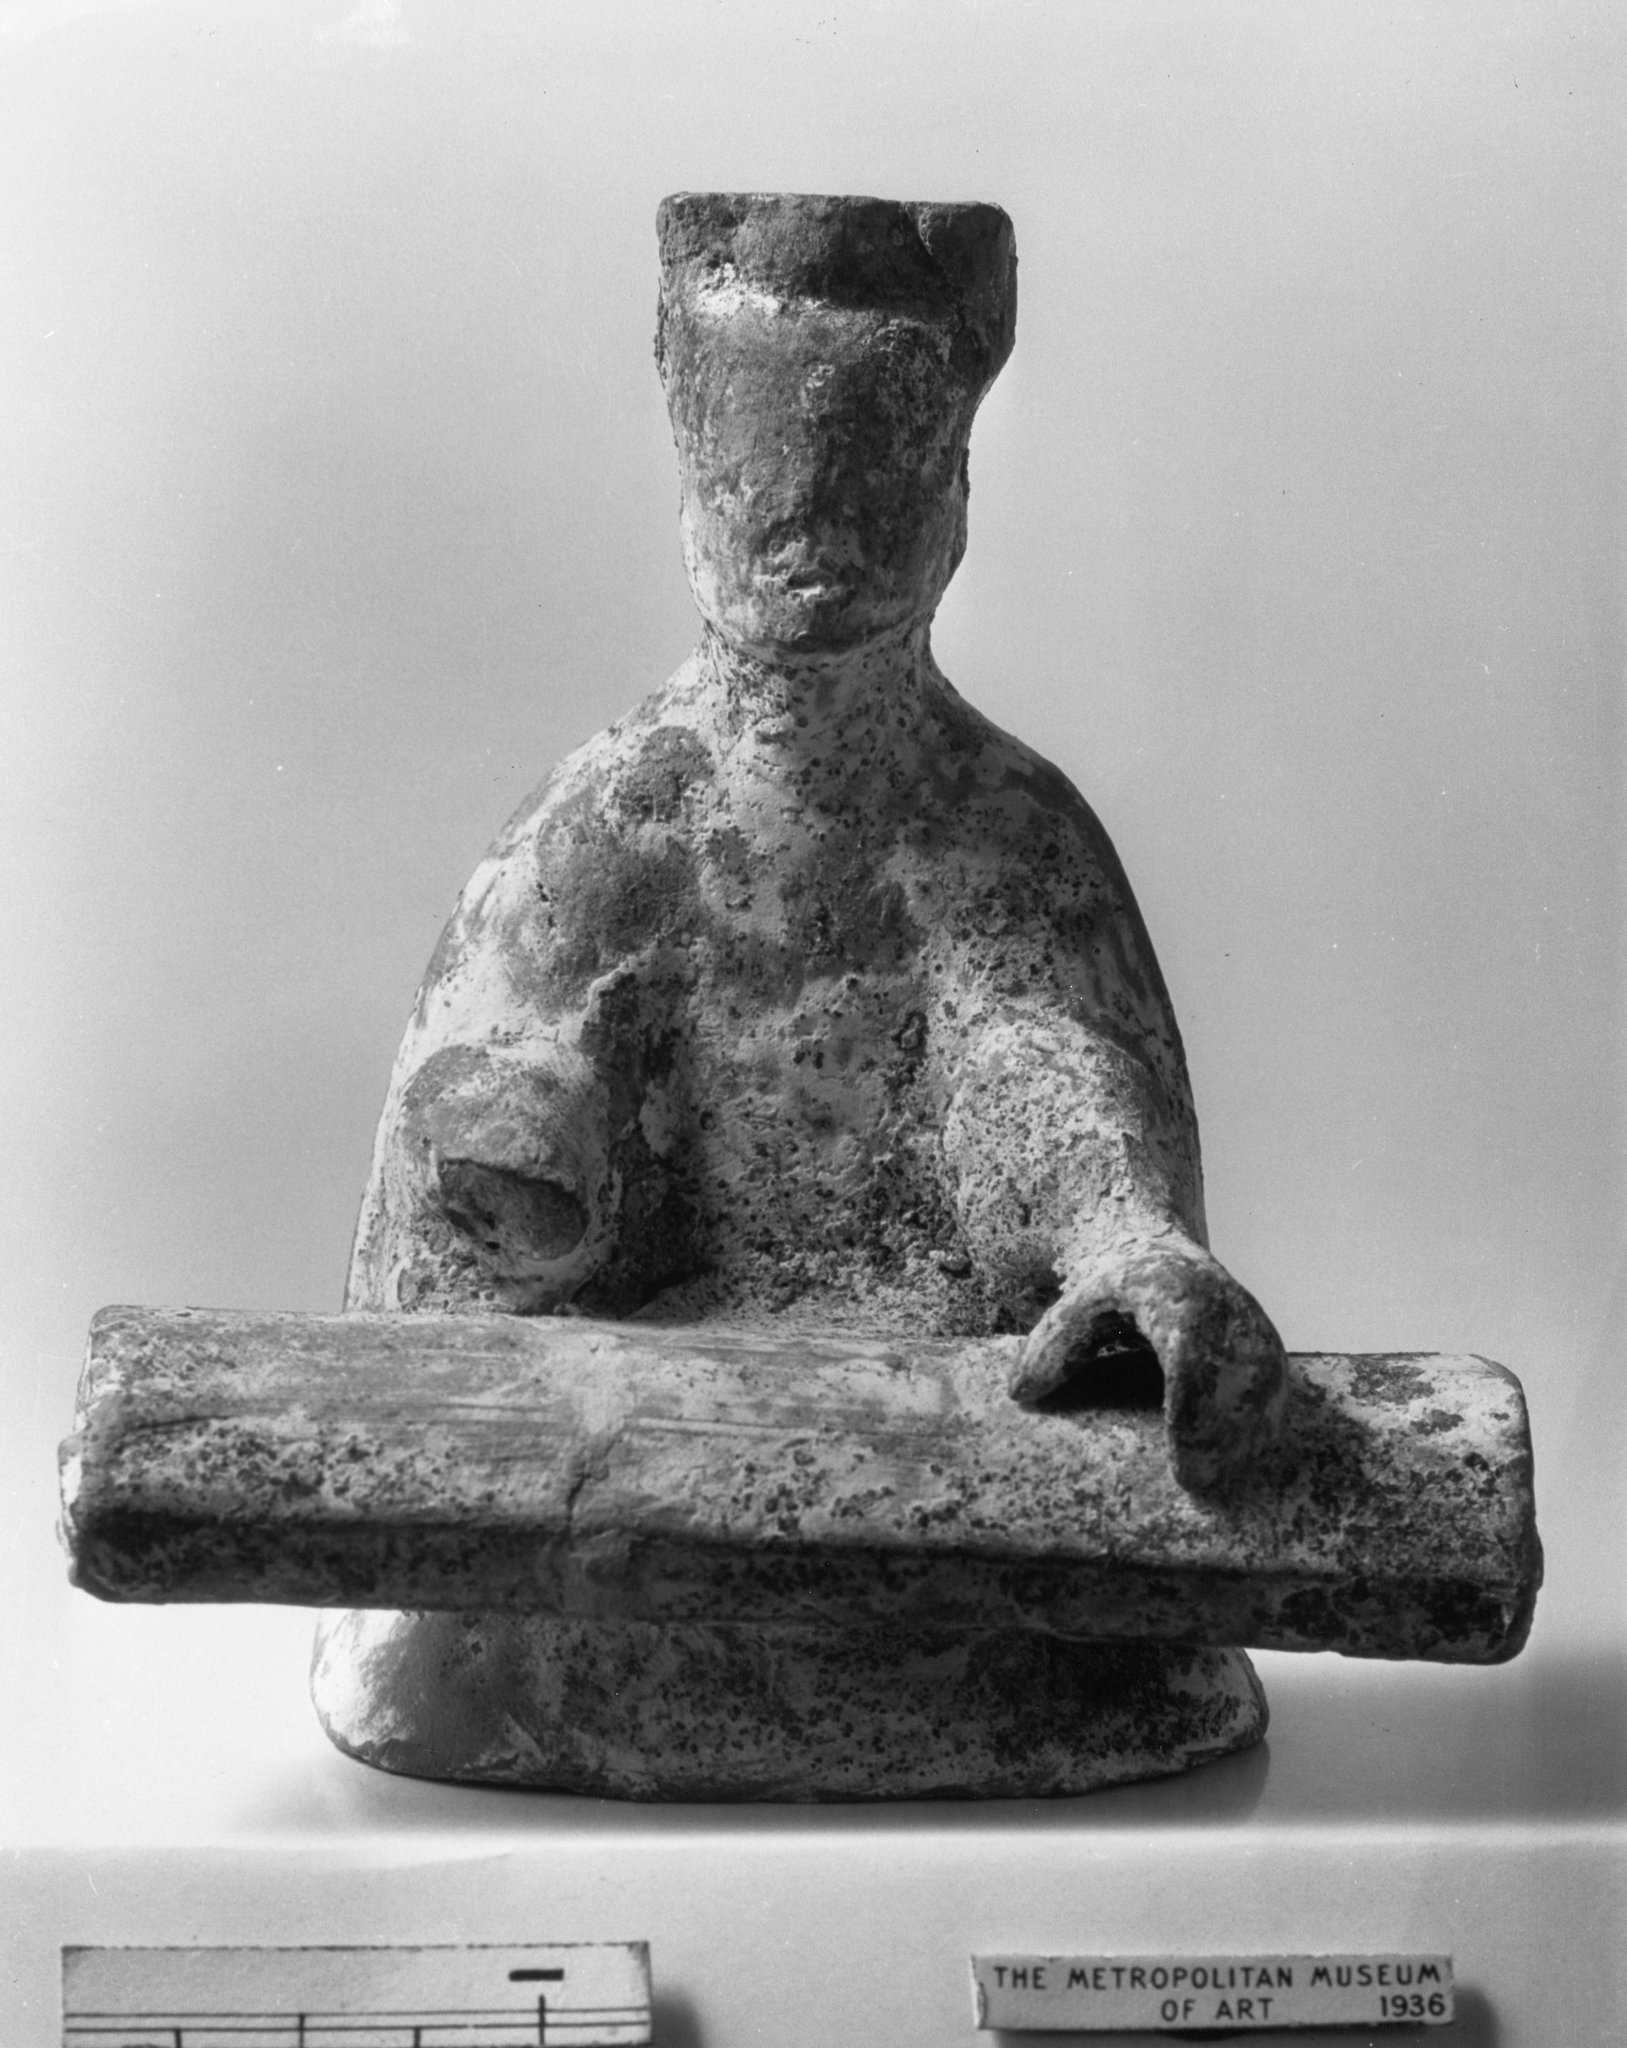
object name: figure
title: Figure of Entertainer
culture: chinese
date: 206 BCE-220 CE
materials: paint, pottery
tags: human figures